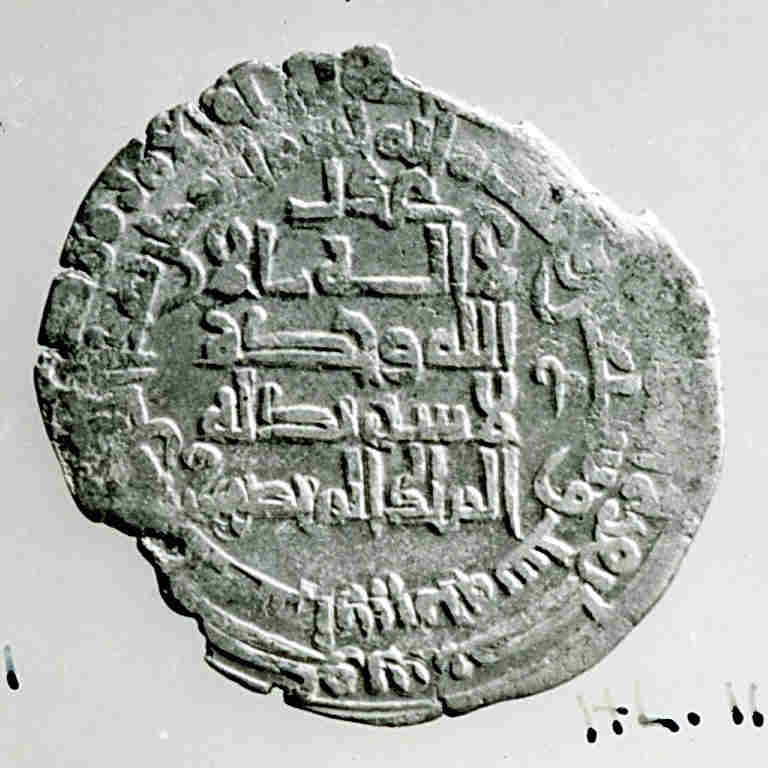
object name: coin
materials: silver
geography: iran